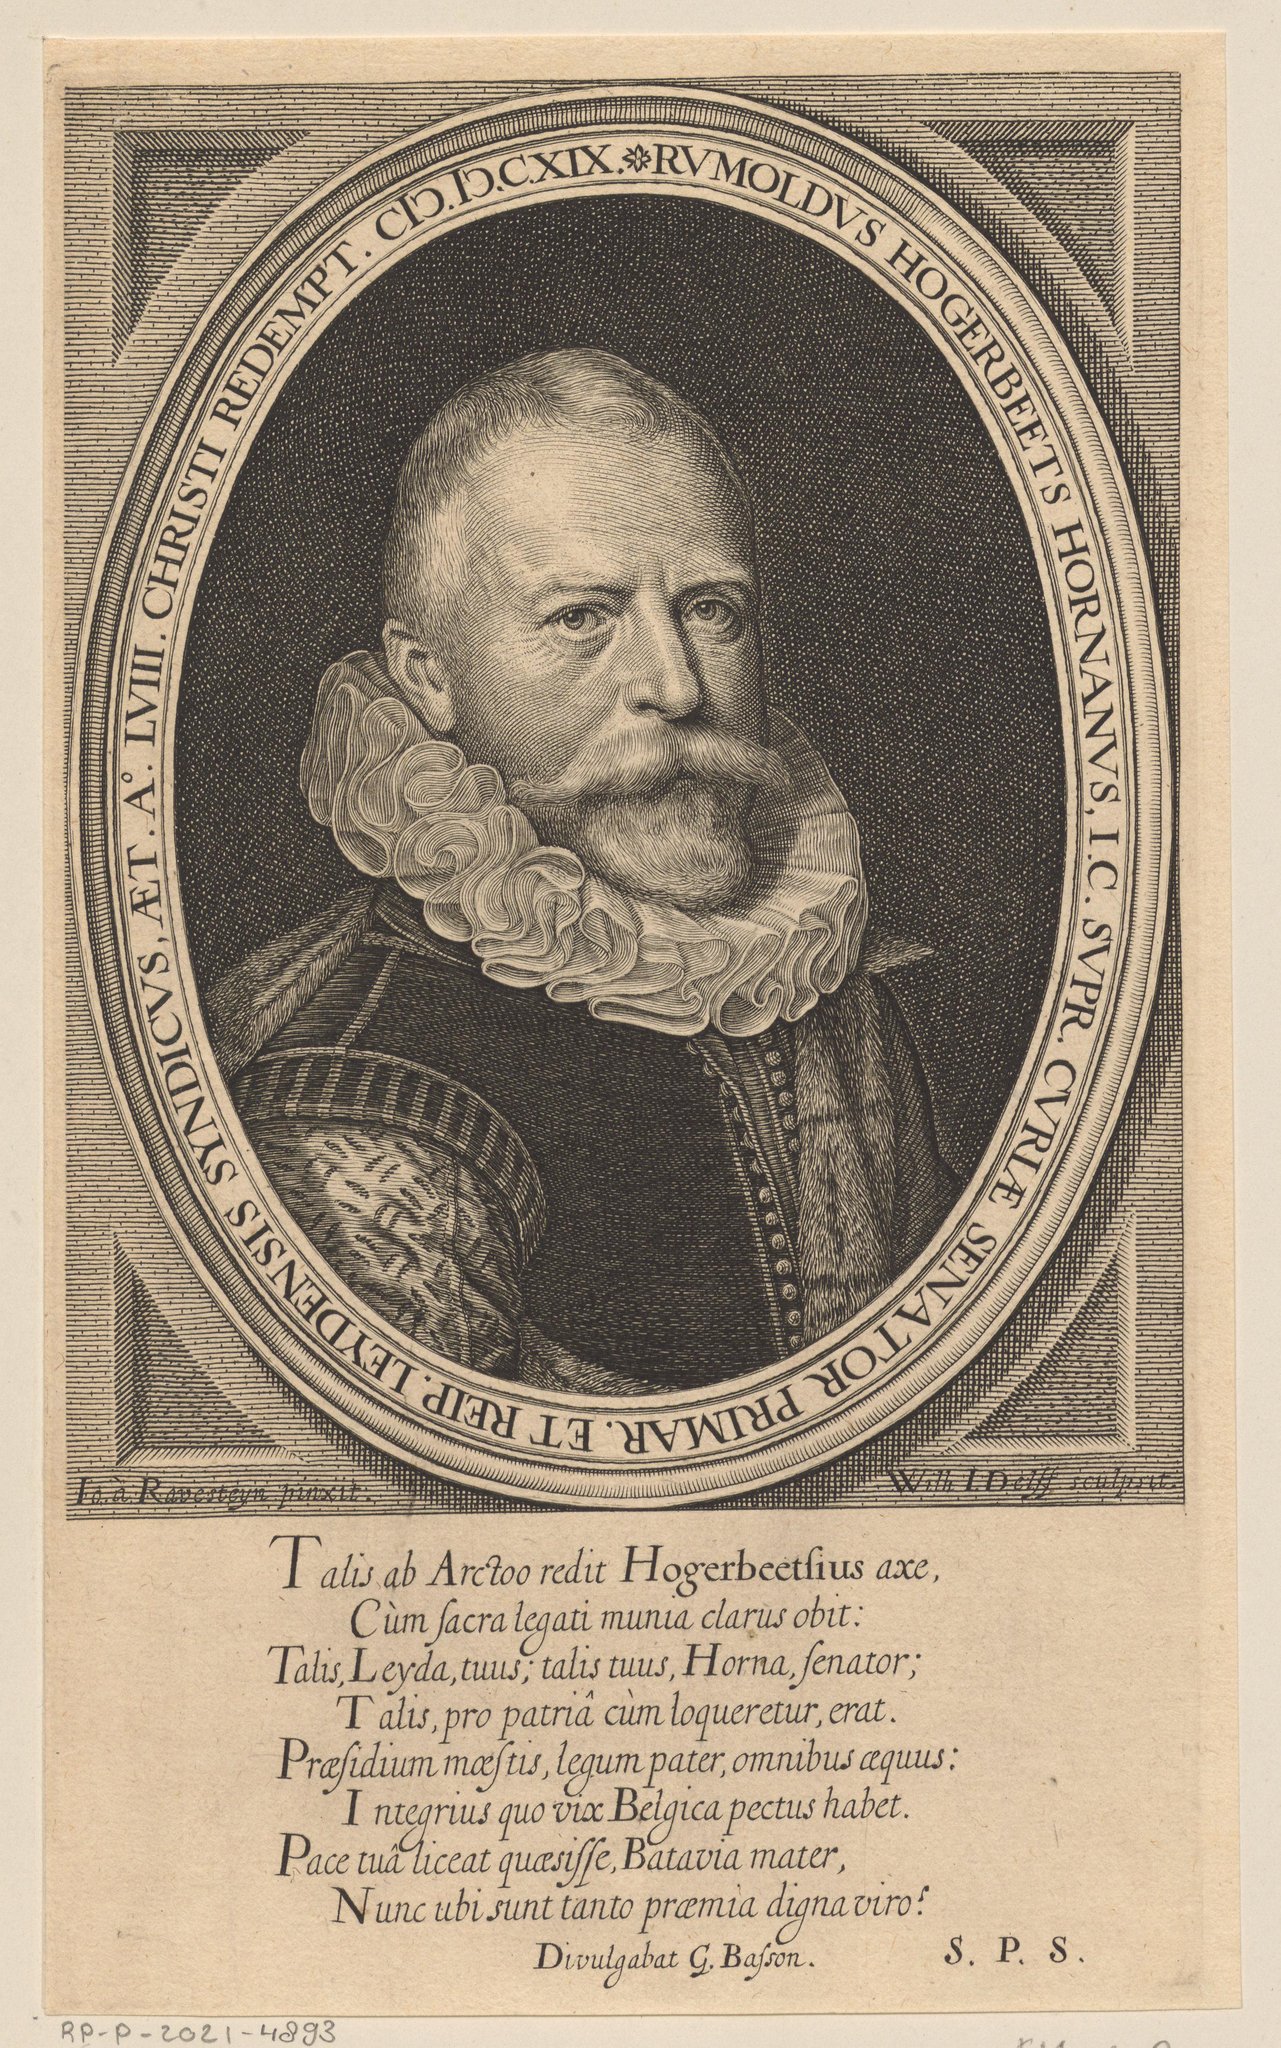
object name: print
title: Portret van Rombout Hogerbeets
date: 1619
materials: paper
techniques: engraving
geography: leiden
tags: hoorn (north holland), historical persons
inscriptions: date